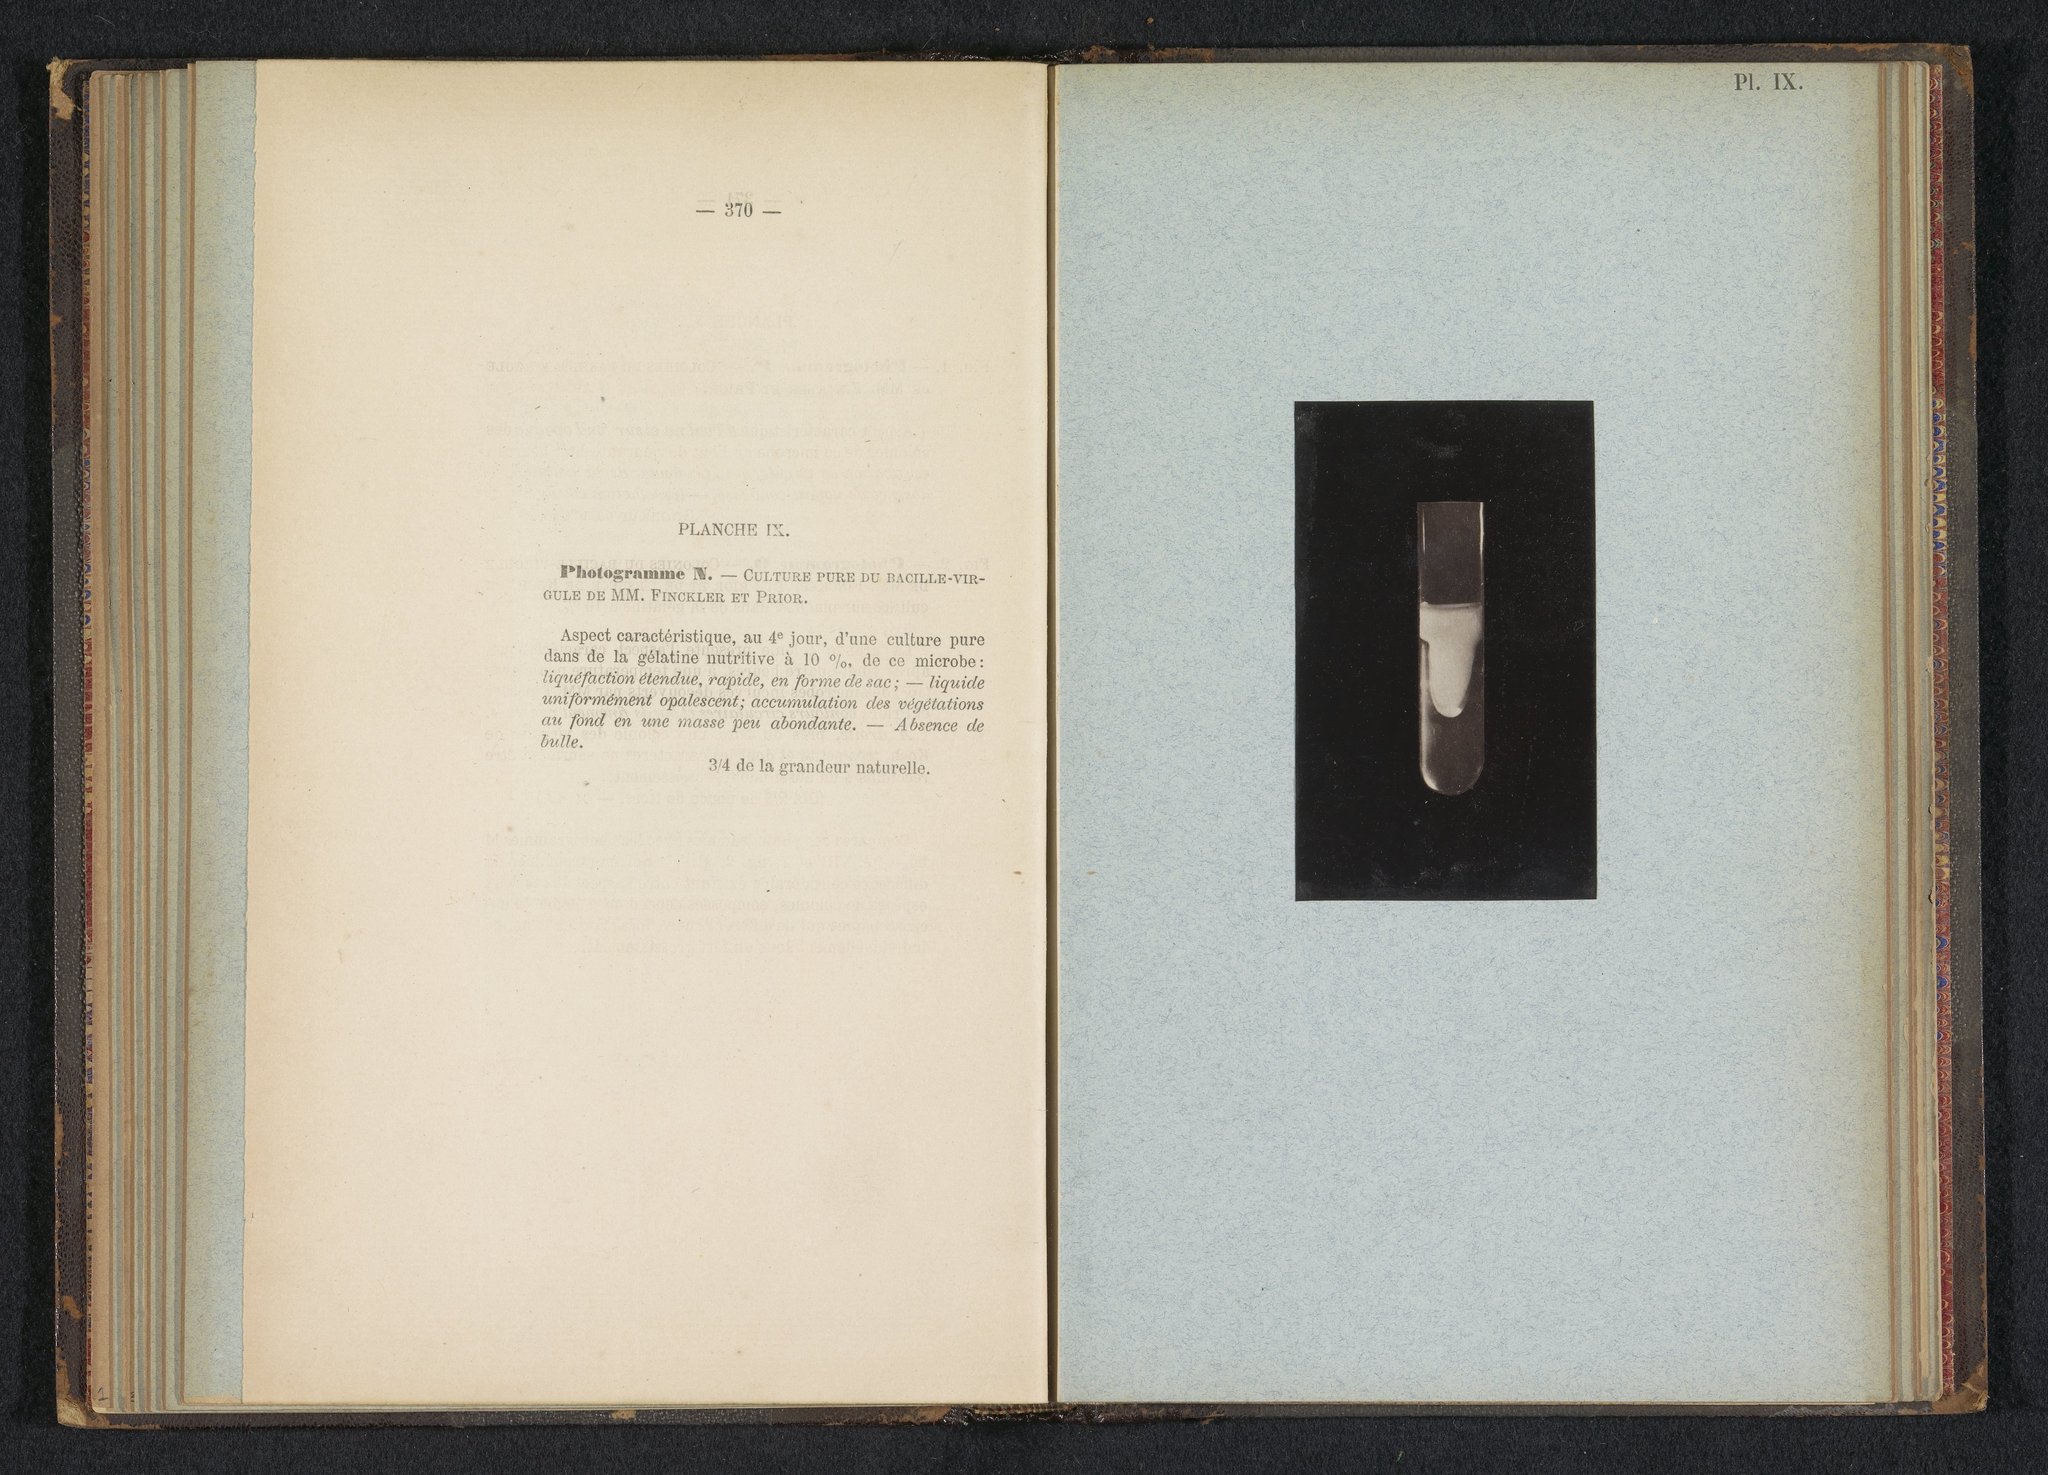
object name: photograph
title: Wetenschappelijke opname van cholera in gelatine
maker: émile van ermengem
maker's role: bioloog, fotograaf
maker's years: 1851-1932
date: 1875-1885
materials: photographic support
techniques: carbon print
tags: diseases affecting the whole body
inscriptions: number: ‘Pl. IX.’, inscription: ‘Photogramme N. - Culture pure du bacille-virgule Mm. Finckler et Prior. (...)’